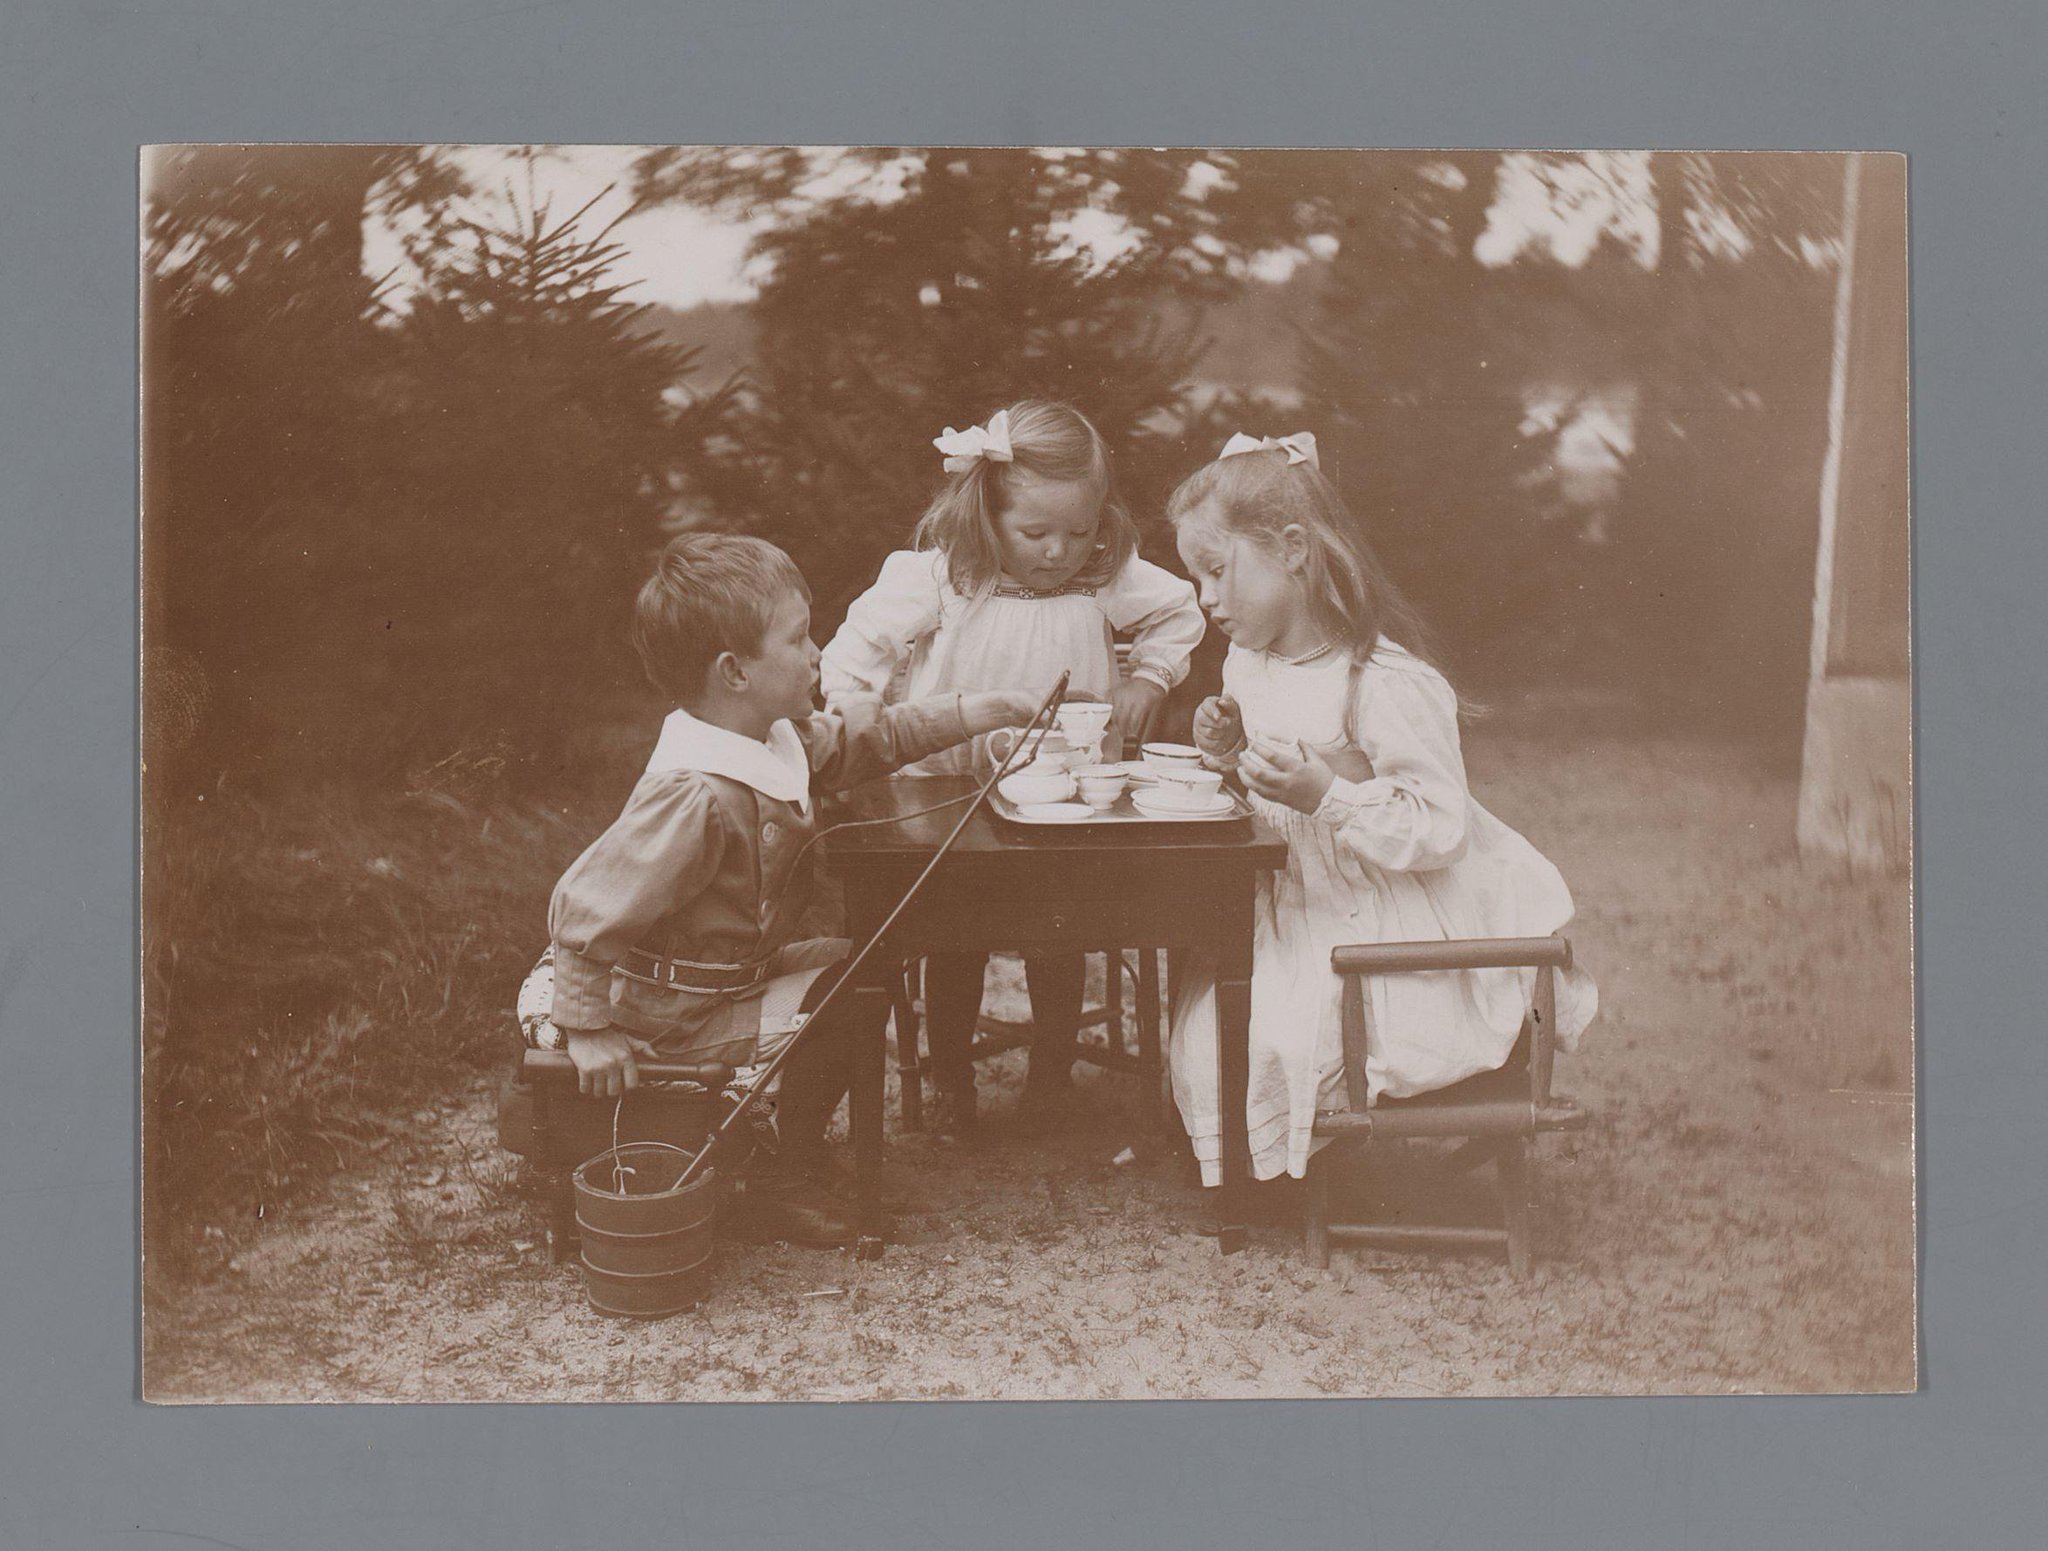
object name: photograph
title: Johanna Geertruida, Johannes Diderik en Anne Madeleine van der Waals spelen met theeservies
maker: johannes diderik van der waals (1873-1971)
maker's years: 1873-1971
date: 1906-1915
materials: photographic support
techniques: collodion silver print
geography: wapenveld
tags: toy tea-set, historical persons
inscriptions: annotation: ‘Hansje, Jan, Anke/ Wapenvelde’